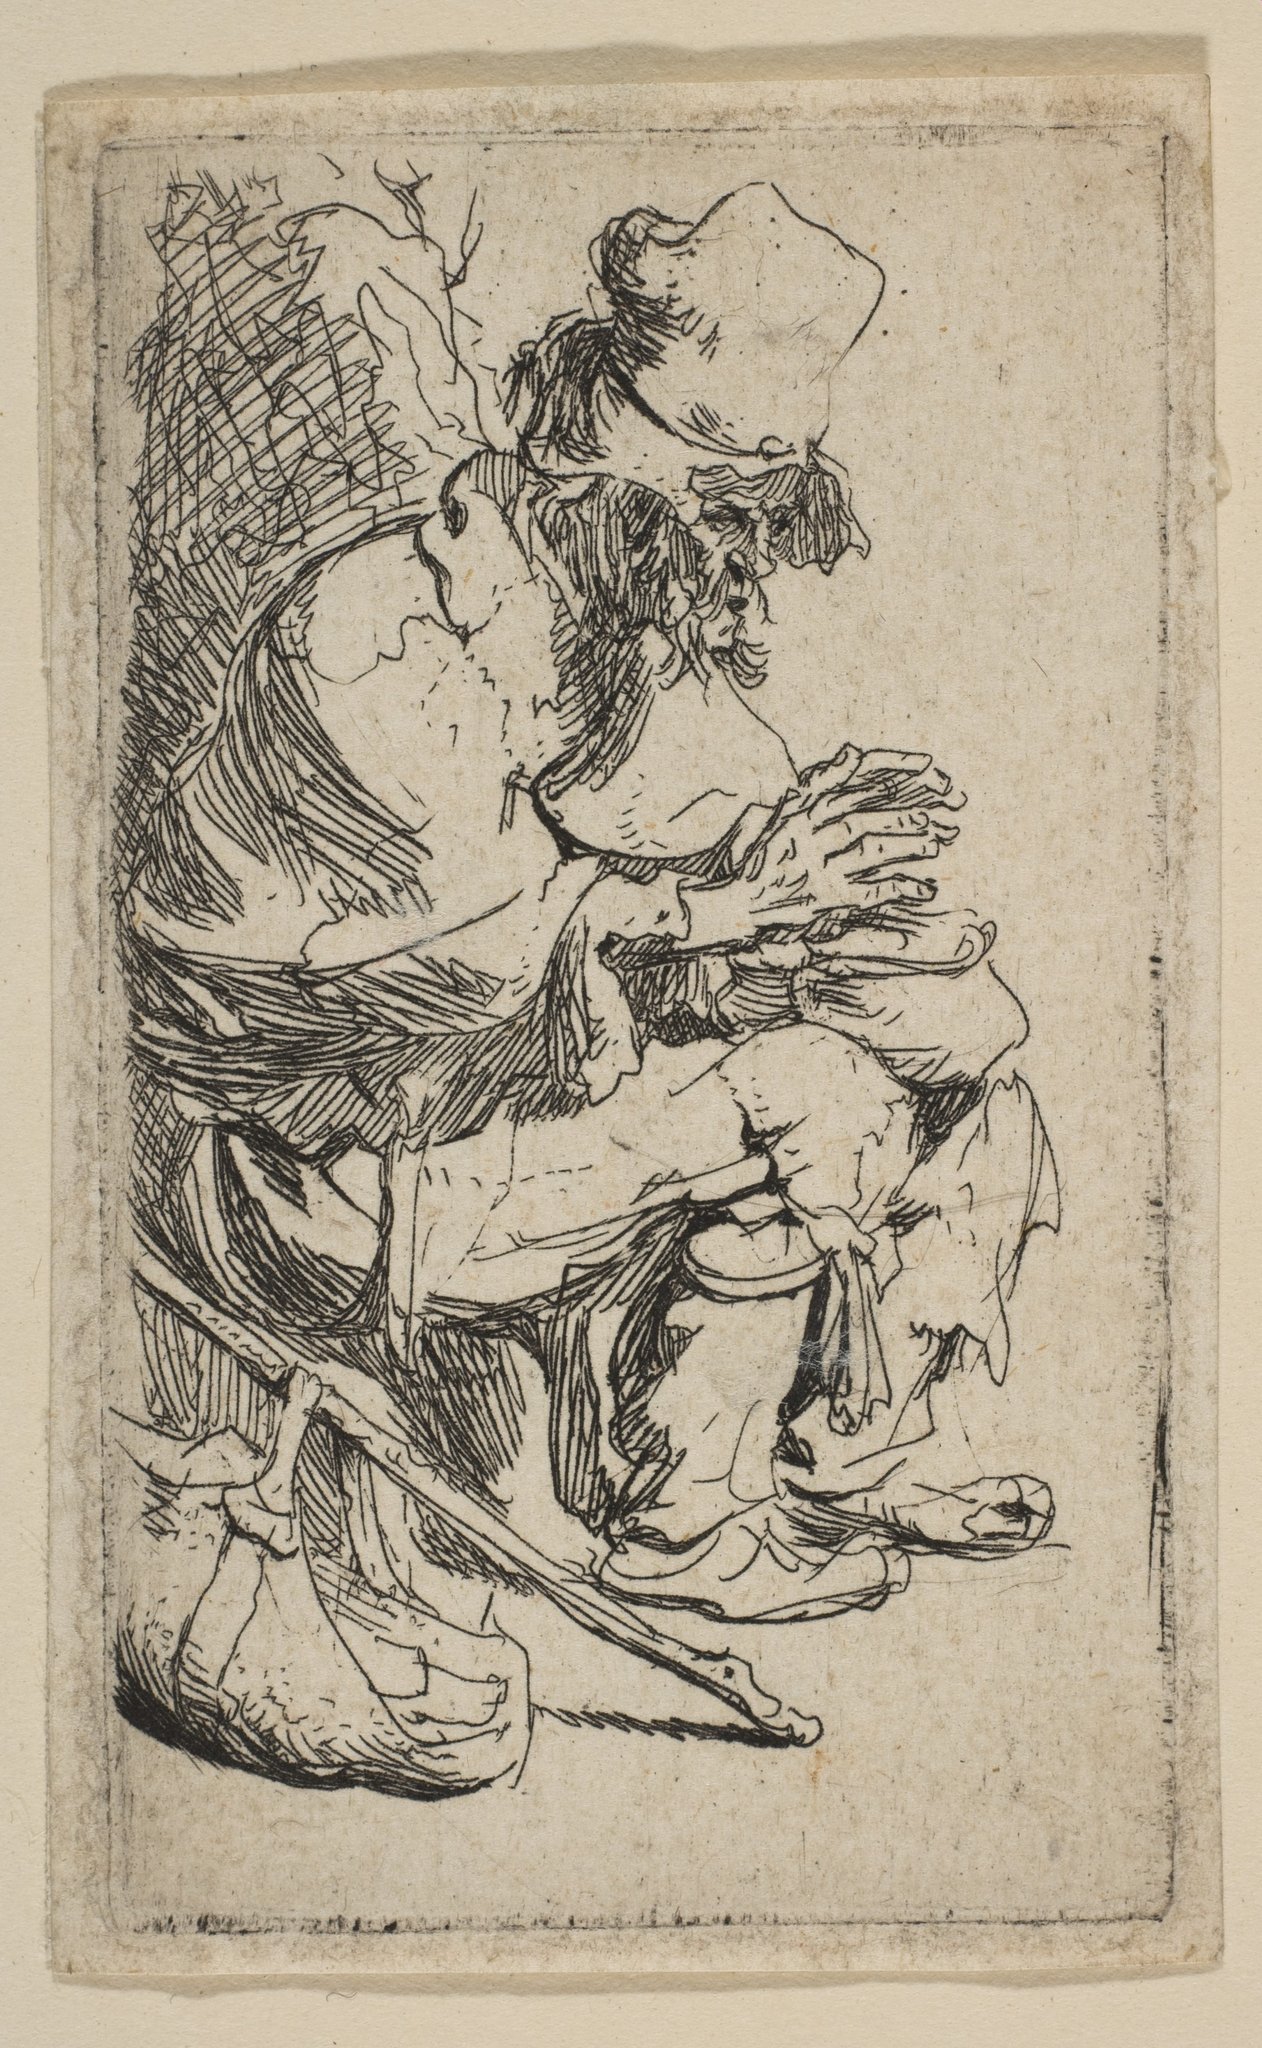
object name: print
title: Beggar Seated Warming His Hands at a Chafing Dish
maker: rembrandt van rijn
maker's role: artist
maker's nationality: dutch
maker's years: 1606-1669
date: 1630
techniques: etching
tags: men